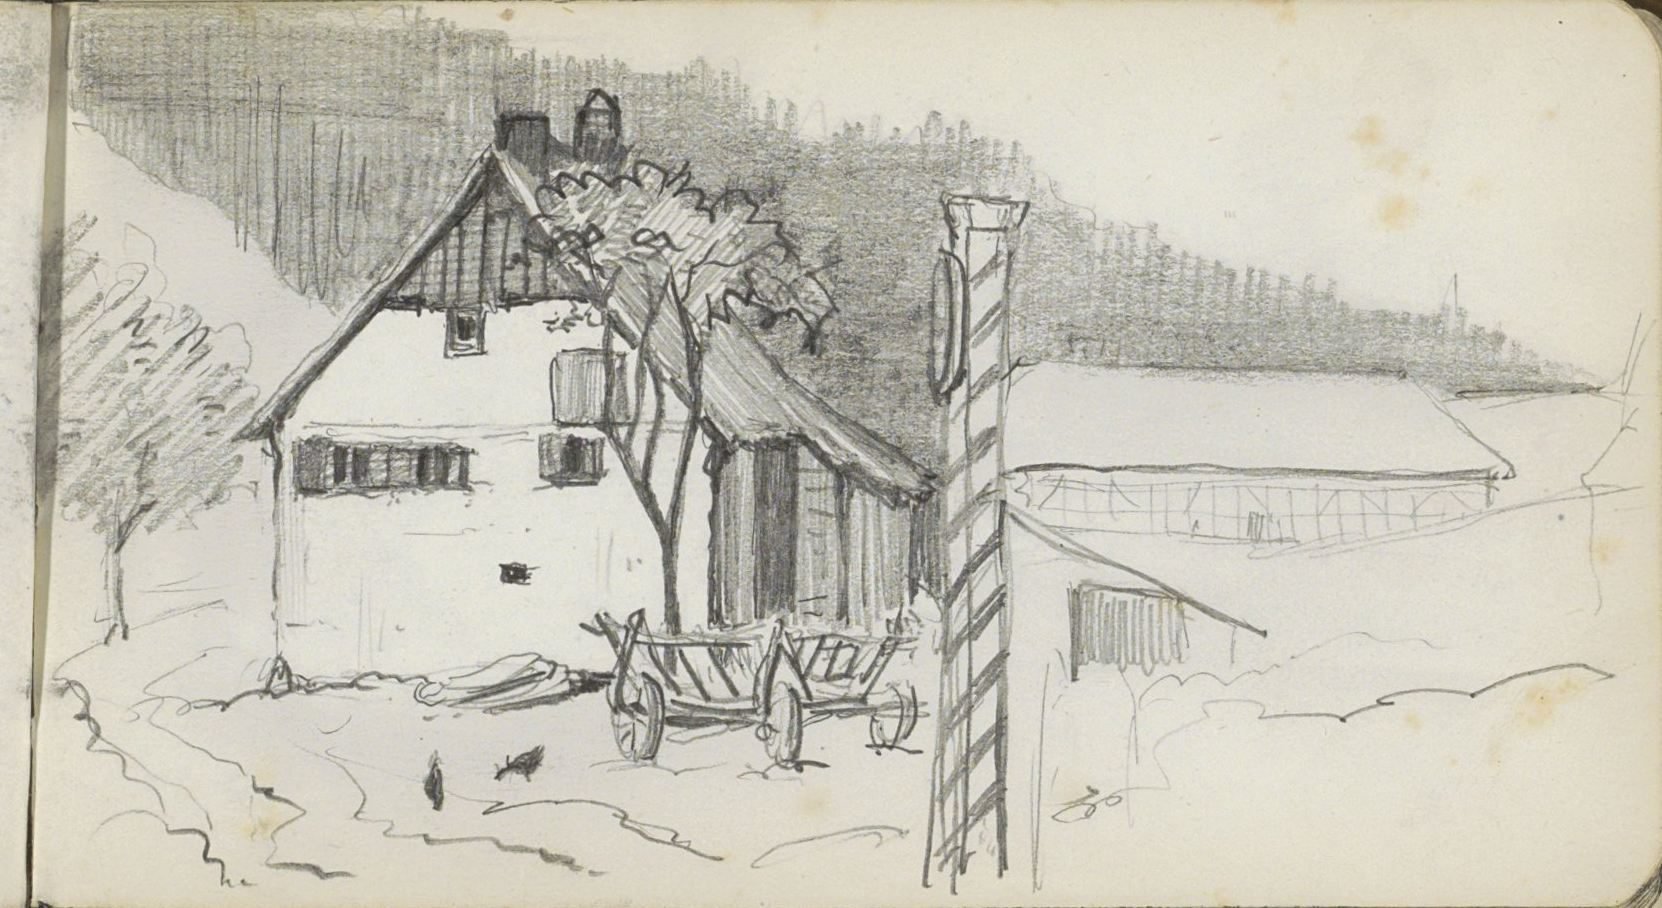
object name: sketchbook leaf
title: Kar op het erf voor een boerderij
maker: geo poggenbeek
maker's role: draughtsman, painter, print maker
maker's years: 1853-1903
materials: paper, pencil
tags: (farm) wagon, freight wagon, cart, farm (building)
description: Blad 40 recto uit een schetsboek met 69 bladen.